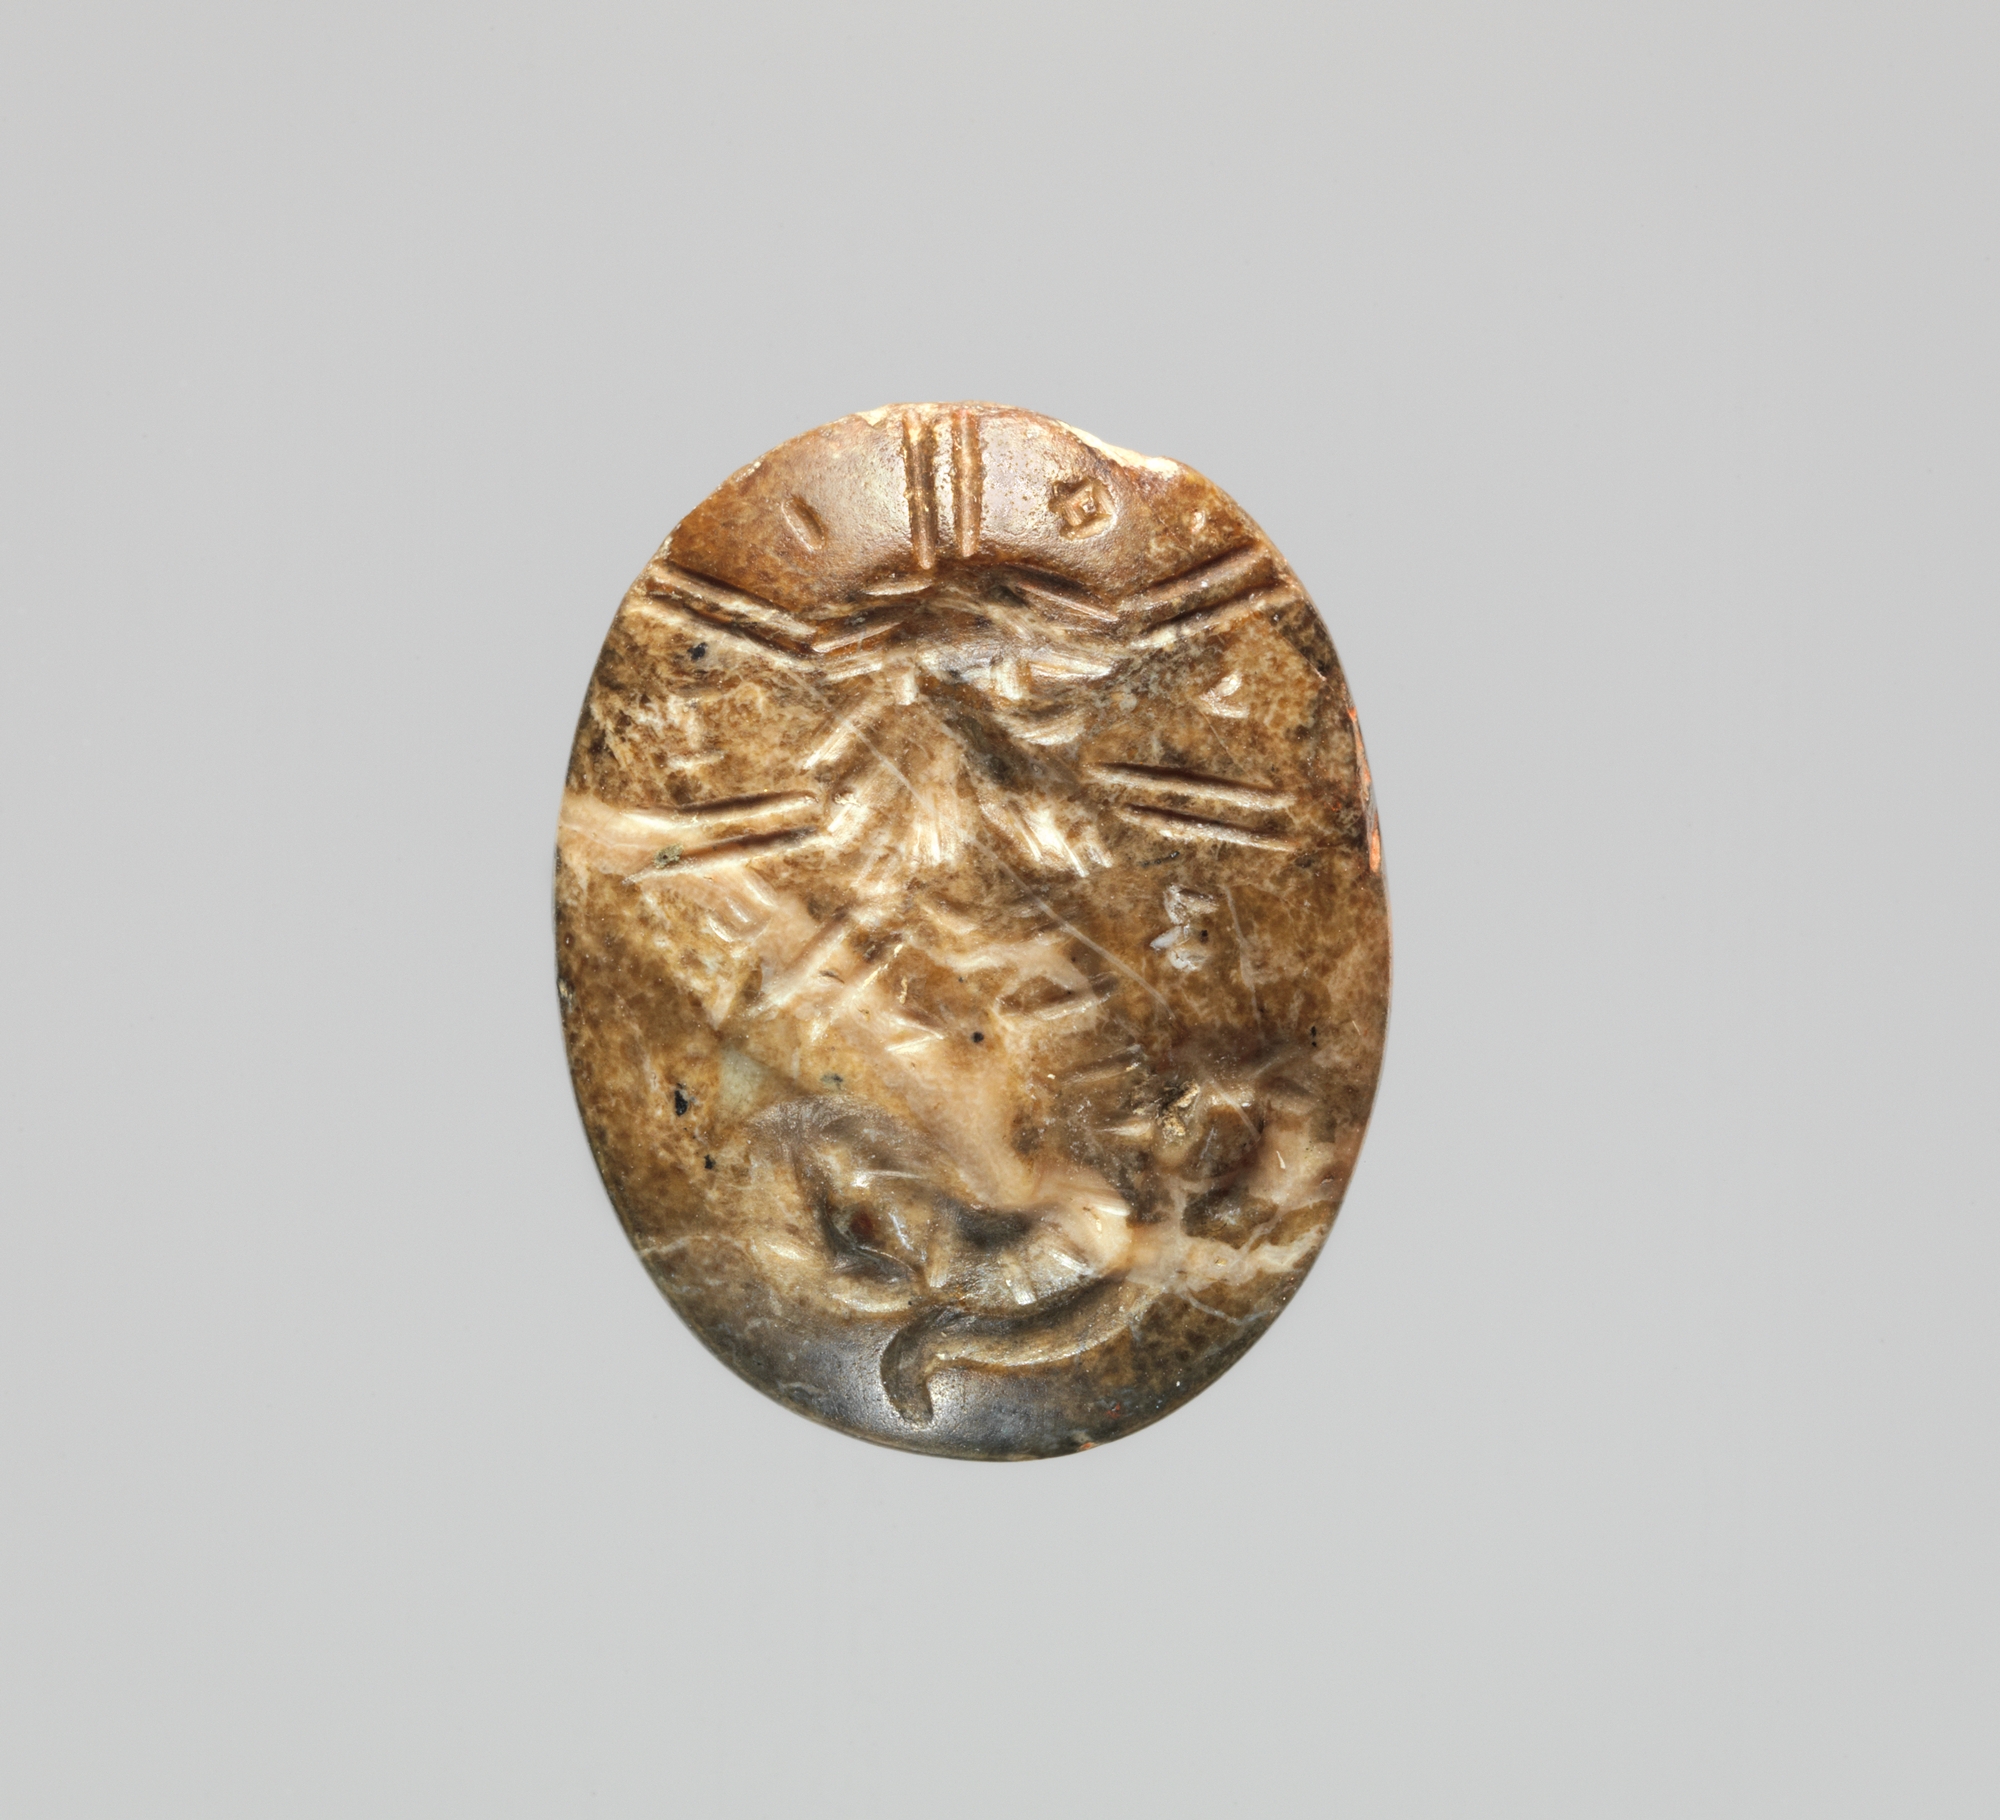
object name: intaglio, magical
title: Steatite intaglio: Lion-headed serpent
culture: roman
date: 101-300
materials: stone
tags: lions,serpents